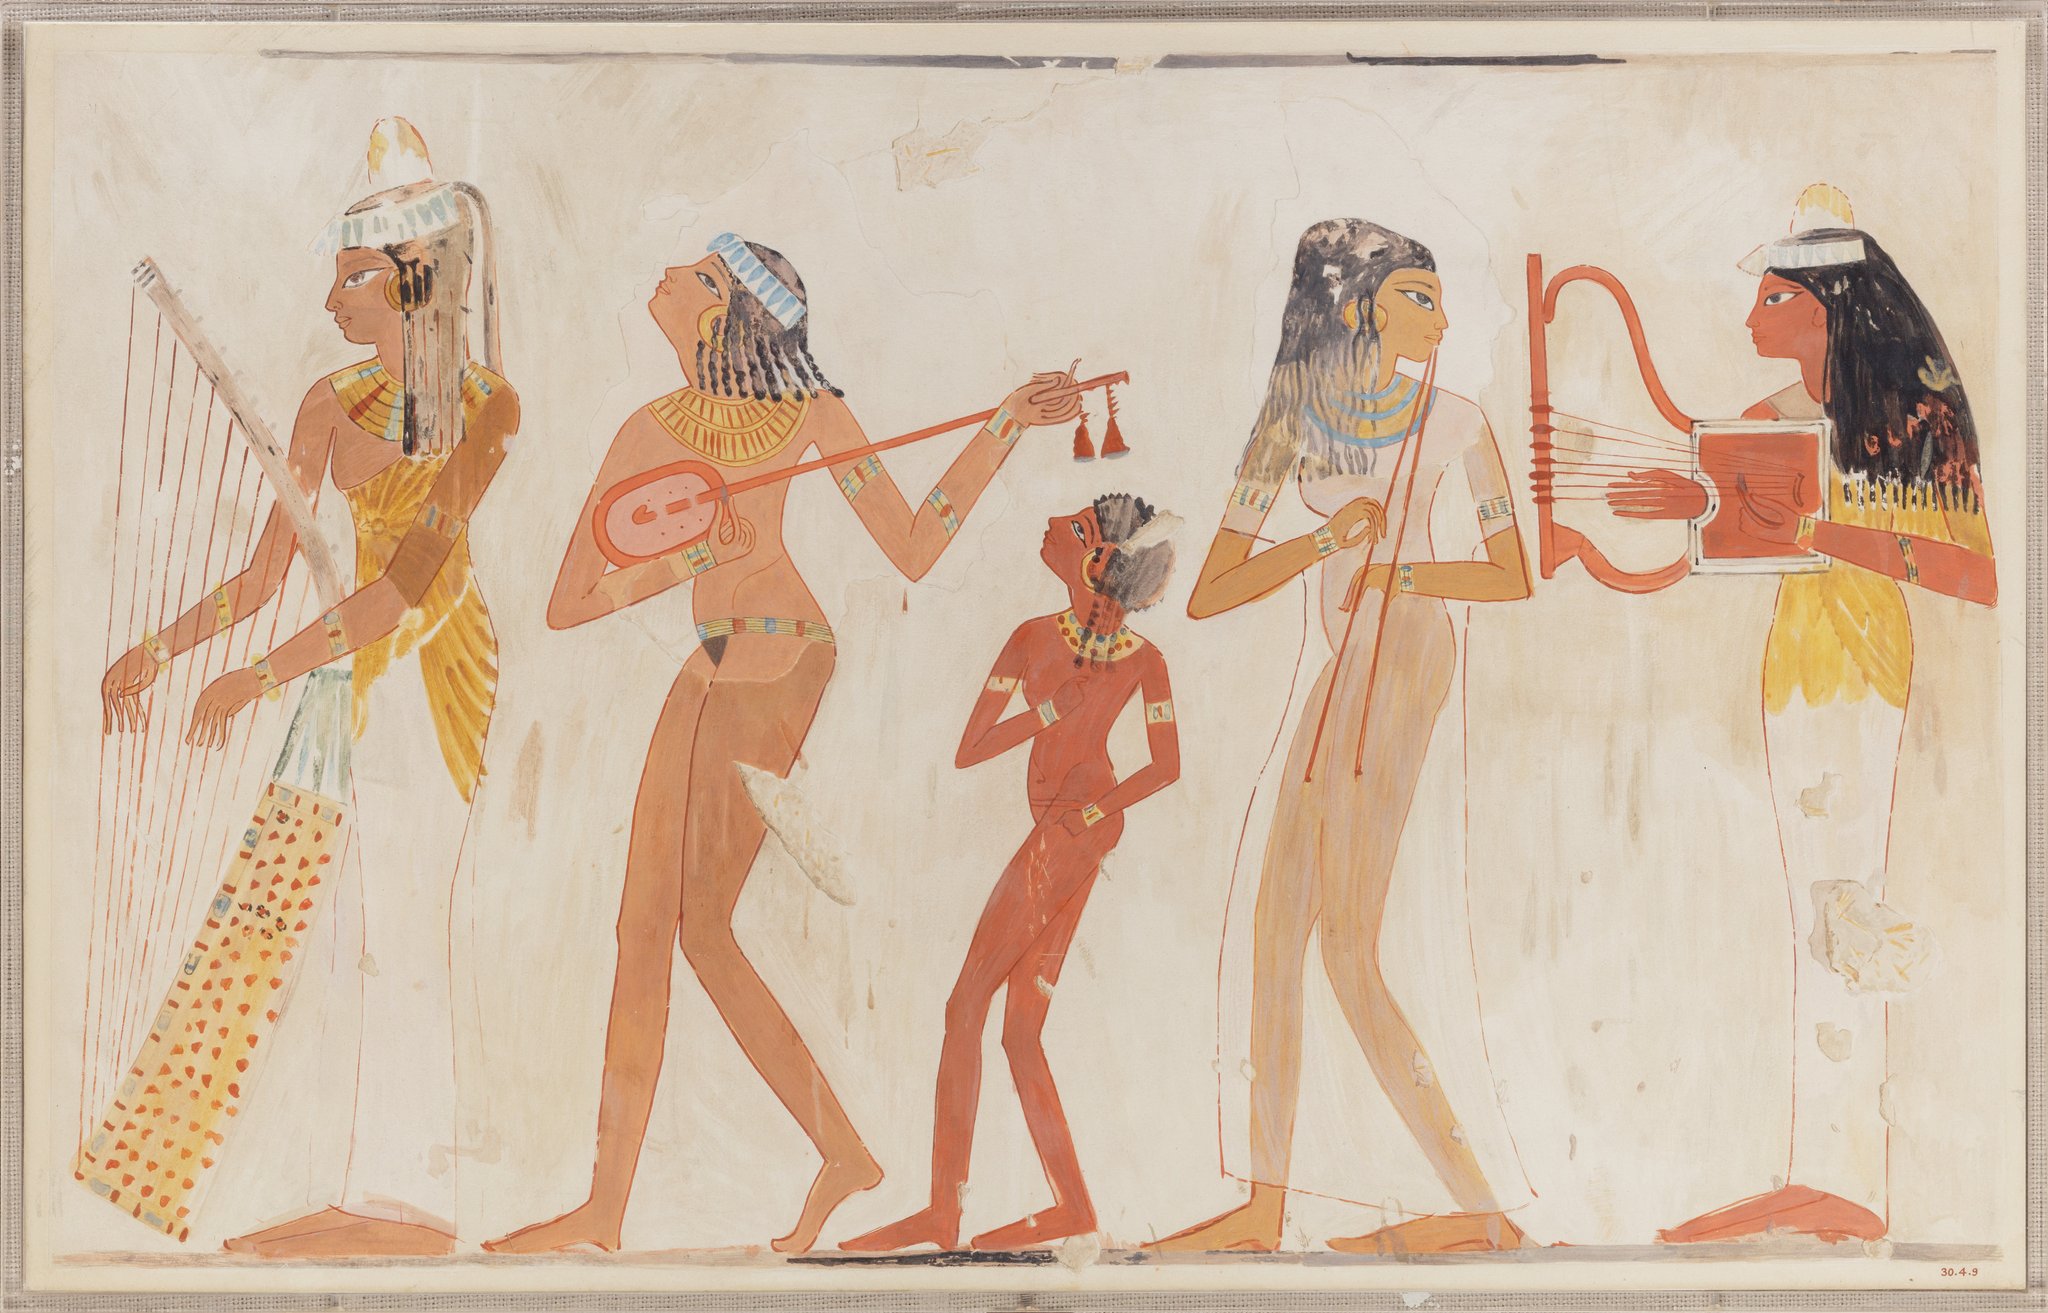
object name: facsimile, djeserkareseneb tt 38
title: Female Musicians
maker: charles k. wilkinson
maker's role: artist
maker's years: 1897-1986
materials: paper, paint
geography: egypt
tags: musical instruments,women,lutes,musicians,drink-and-be-merry,love-poetry